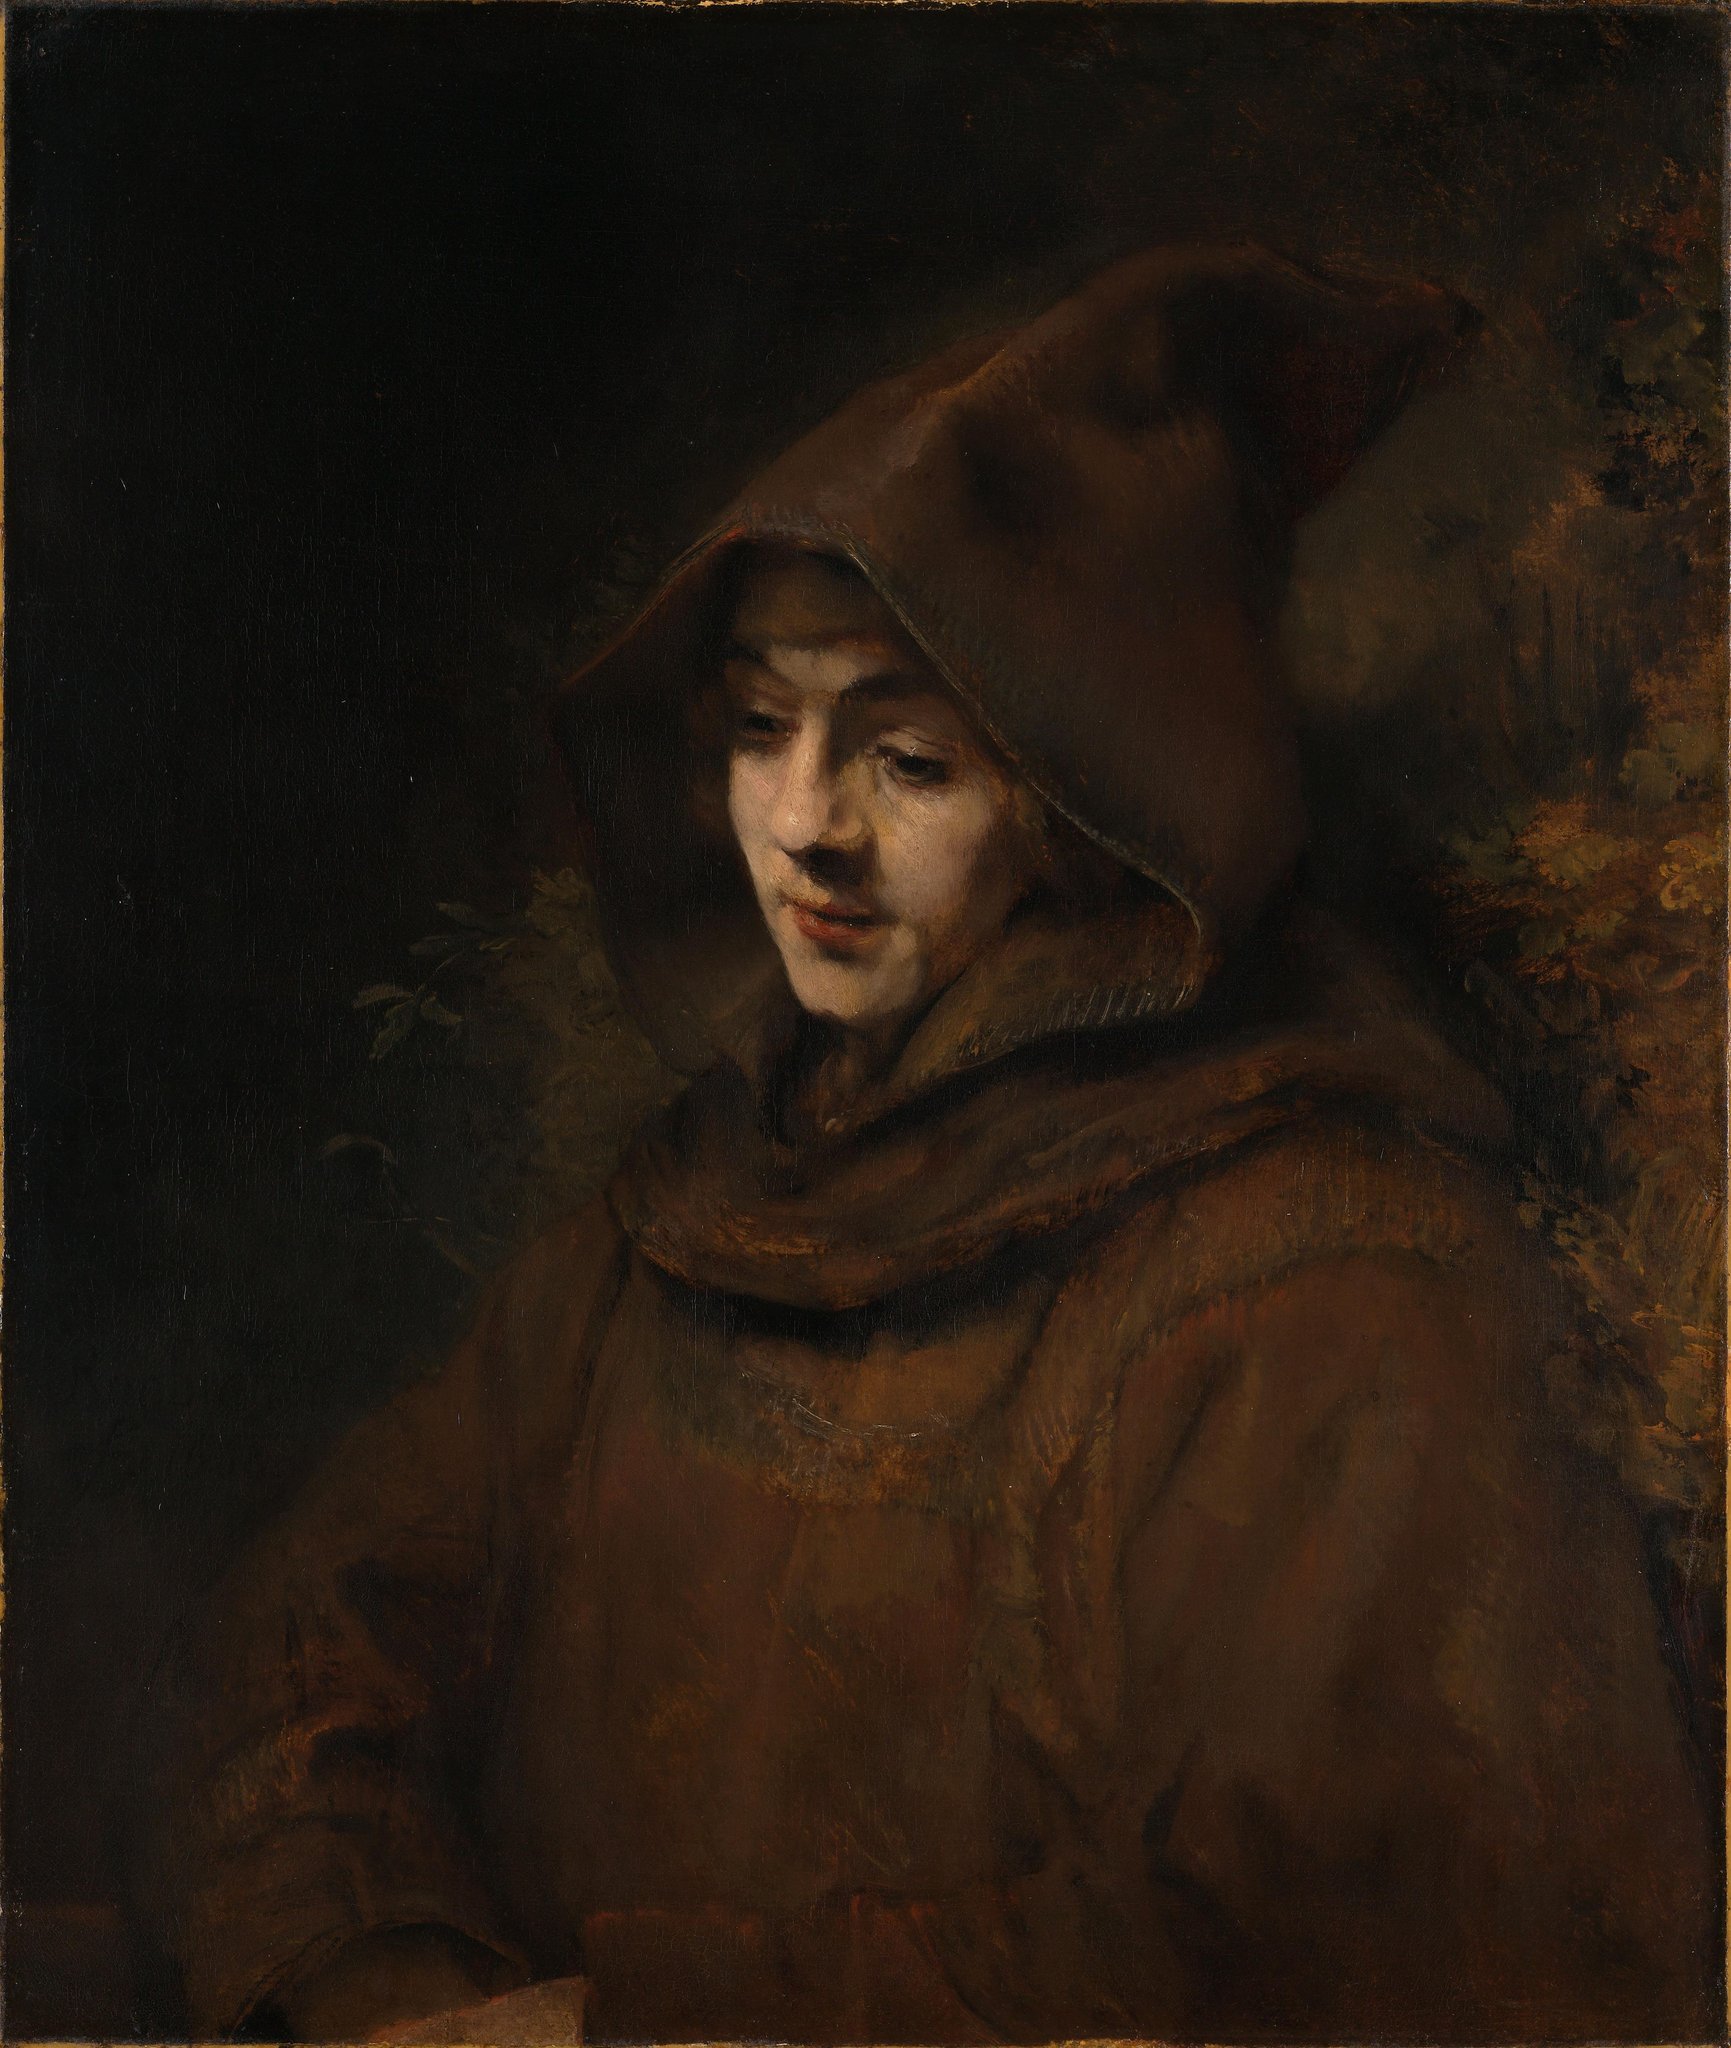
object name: painting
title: Rembrandt's son in a monk's habit, possibly in the guise of St Francis of Assisi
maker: rembrandt van rijn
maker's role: draughtsman, painter, print maker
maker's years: 1606-1669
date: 1660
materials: canvas, oil, paint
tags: amsterdam, draughtsman, historical persons, monk(s), friar(s), founder of the order of friars minor (franciscans), francis(cus) of assisi; possible attributes: book, crucifix, lily, skull, stigmata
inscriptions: signature and date: ‘Rembrandt f. 1660’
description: Rembrandt portrayed his son Titus with downcast eyes and wearing a Franciscan habit. The rules of this monastic order prescribed a life of poverty and humility. Indicative of this are the coarse robe and the introspective gaze on the boy’s gaunt face, on which Rembrandt has focussed all his attention. The surroundings, with rocks and bushes, are only summarily suggested.